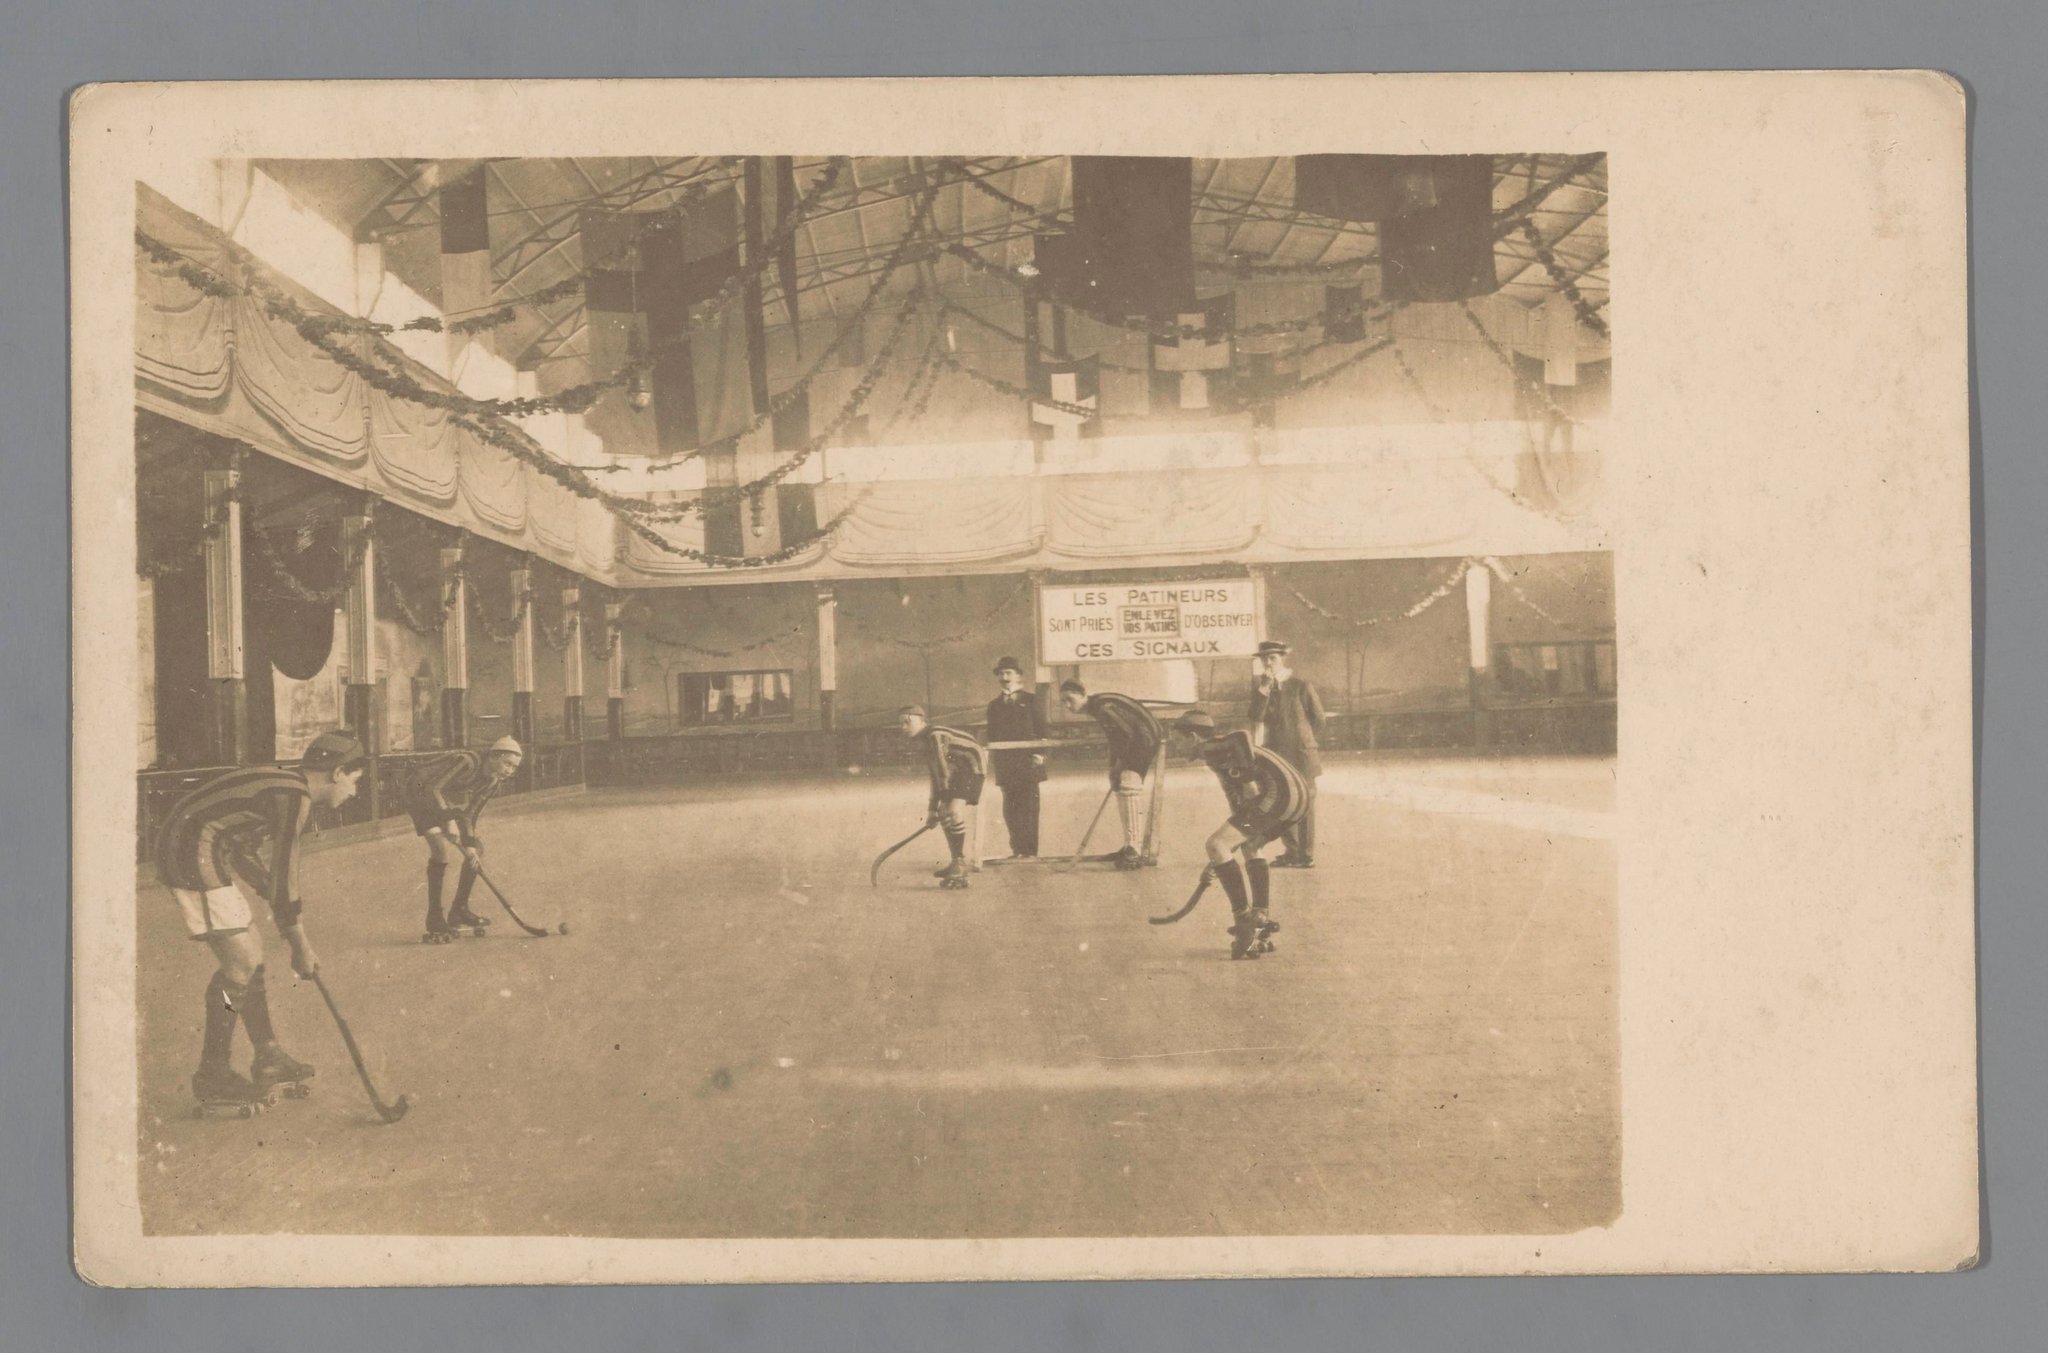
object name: ansichtkaart, prentbriefkaart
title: Hockeyspelers op rolschaatsen in een sporthal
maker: Anonymous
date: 1910-1930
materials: photographic support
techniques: gelatin silver print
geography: switzerland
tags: hockey, roller-skating, roller-skates